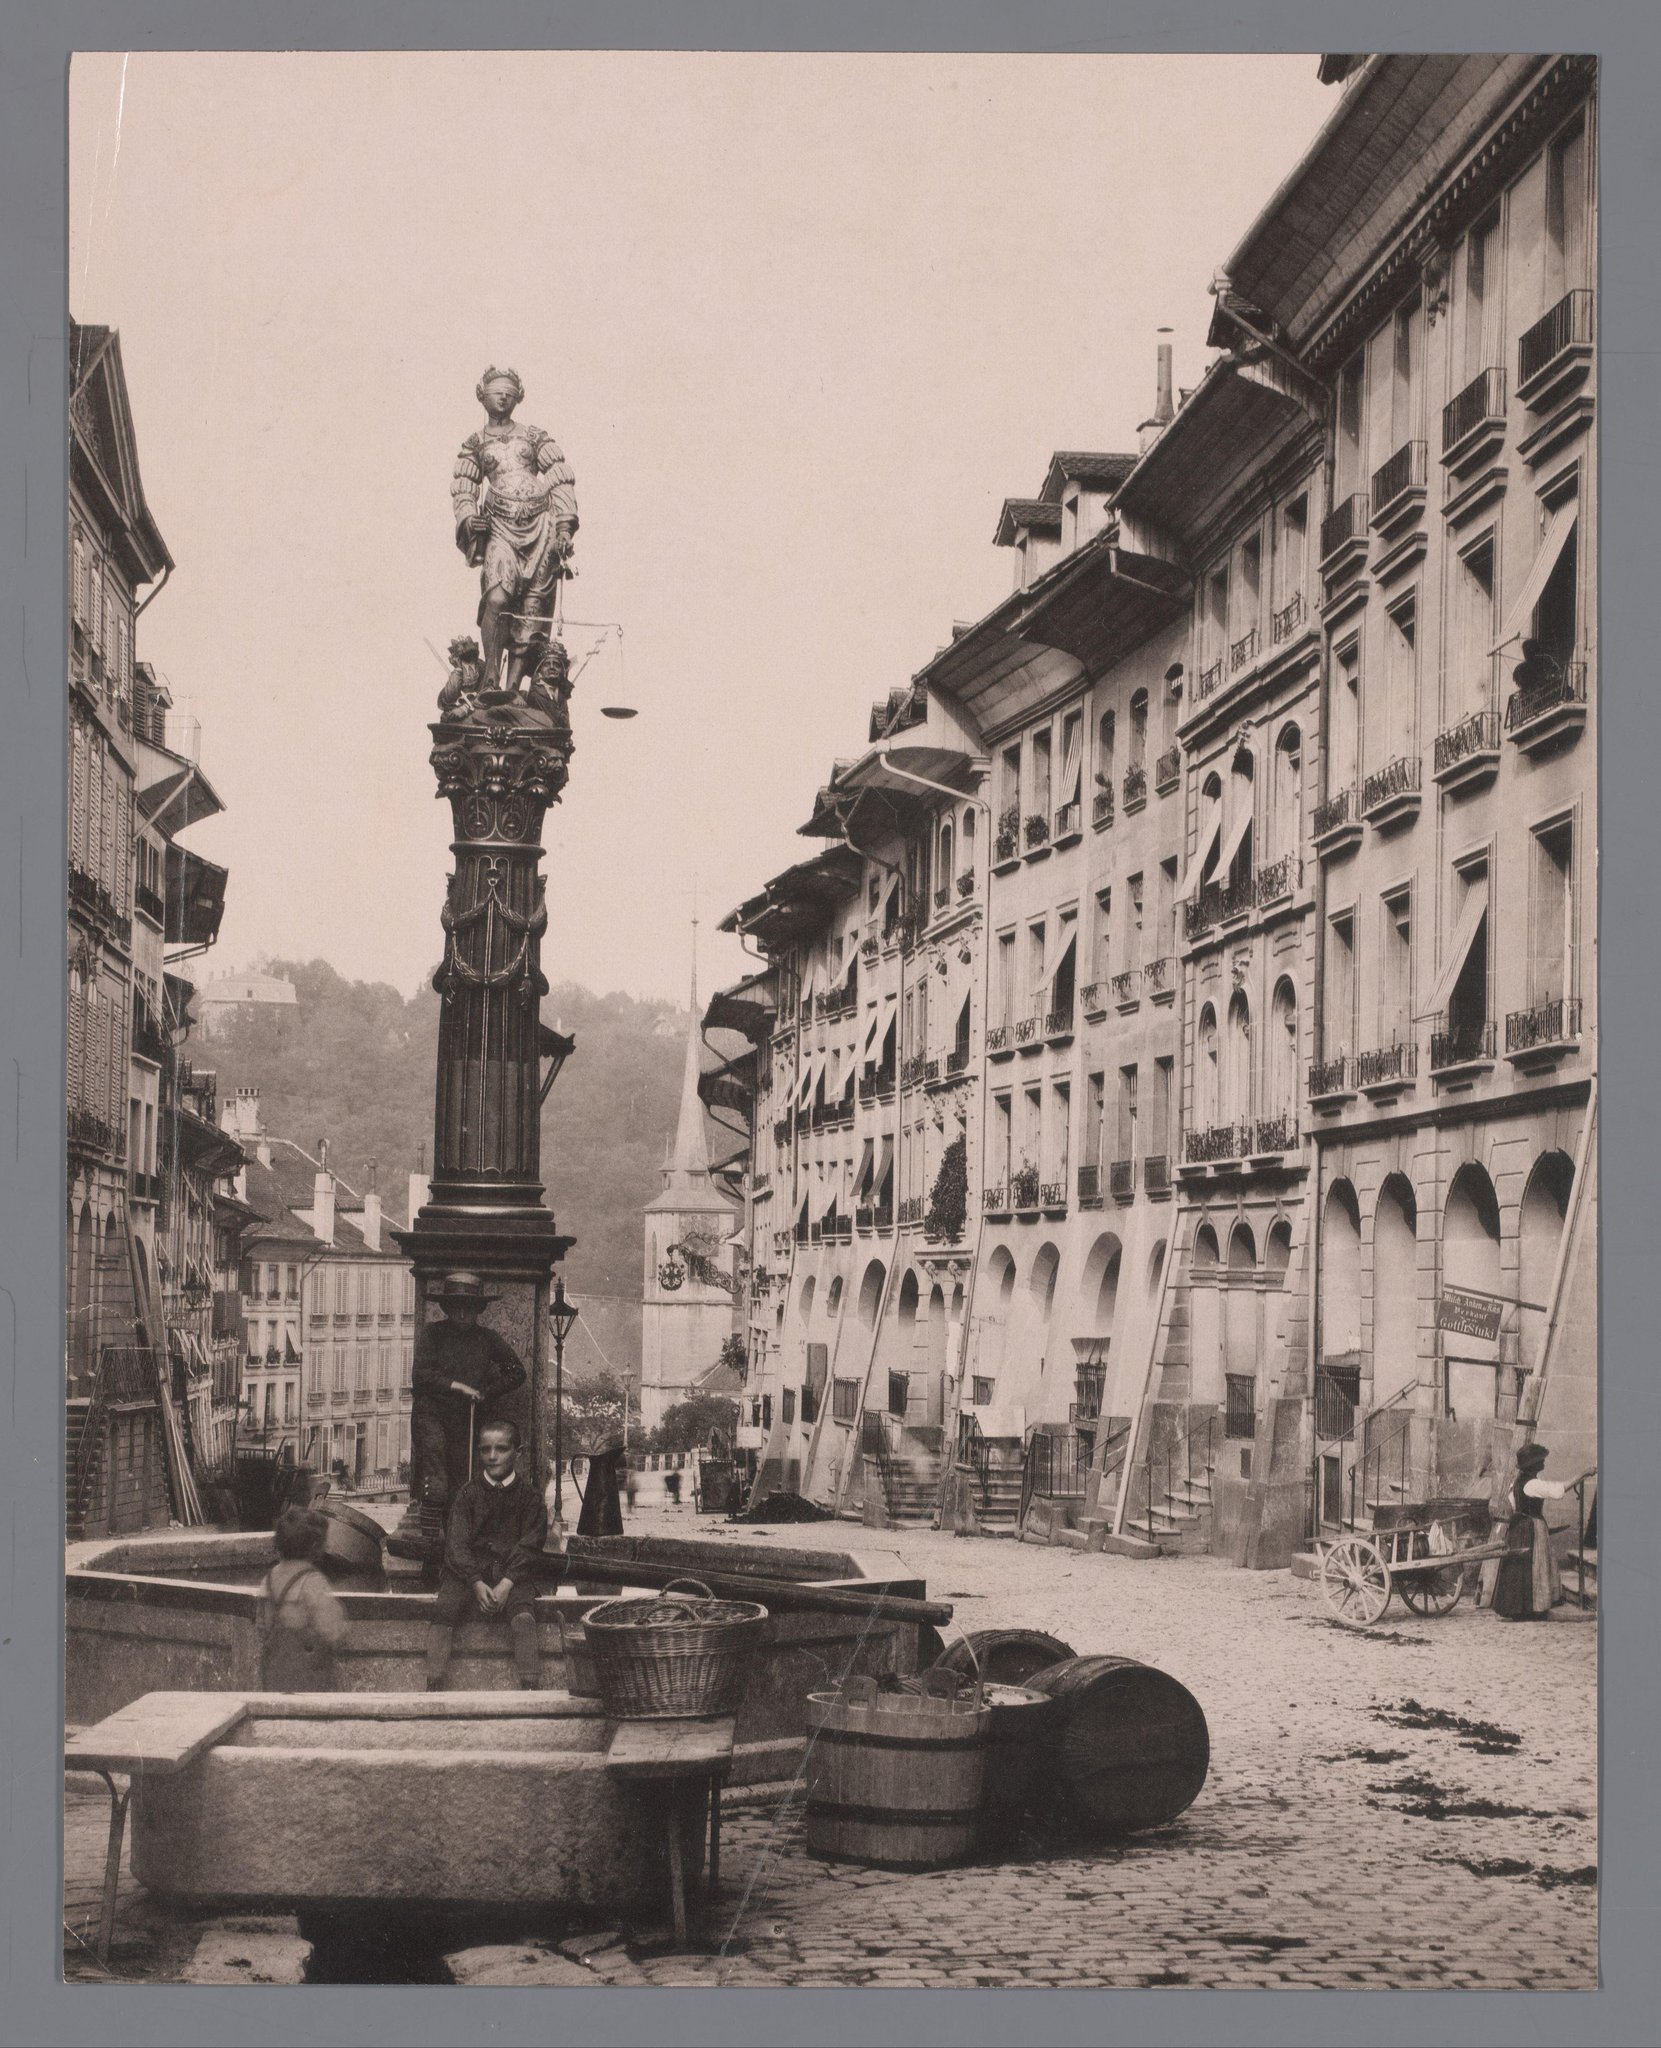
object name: photograph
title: Gezicht op een plein met huizen, een beeld van Vrouwe Jusititia in Oostenrijk, Duitsland, Italië, Zwitserland [?]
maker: Anonymous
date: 1890-1925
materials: paper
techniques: albumen print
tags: europe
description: Gezicht op een plein met een fontein/put met een beeld van Vrouwe Jusititia, Oostenrijk, Duitsland, Italië, Zwitserland [?]. Bij de fontein/put zijn 3 jongetjes te zien, twee darvan kijken in de camera. Rechts een vrouw met een handkar, en een uithangbord van winkel "Gotfr. Stuki".